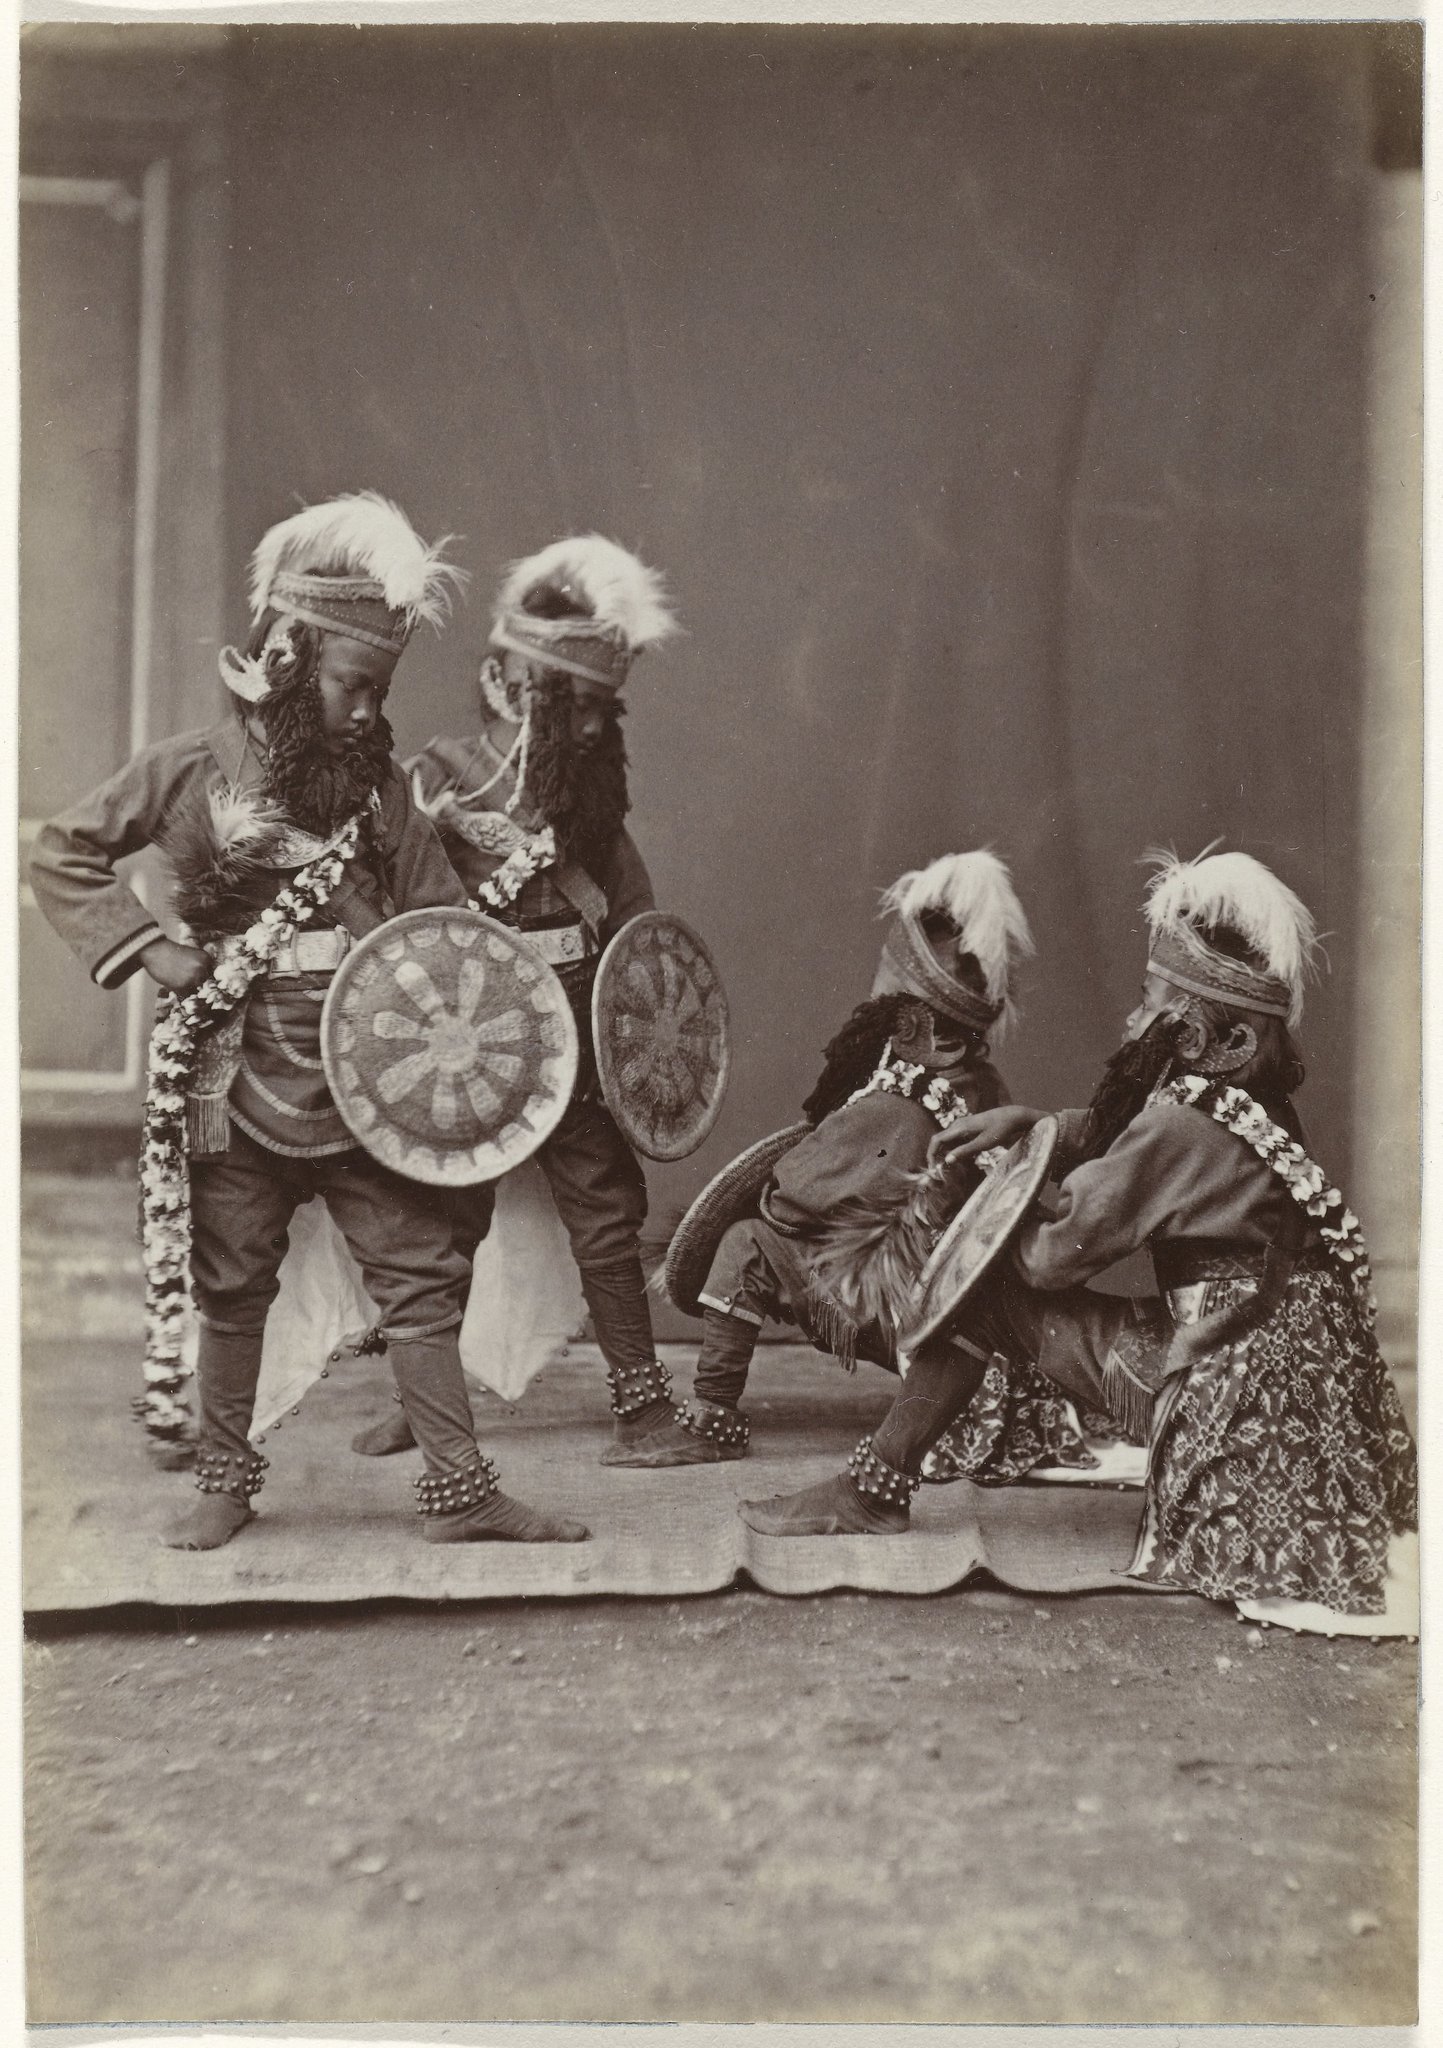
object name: photograph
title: Studioportret van vier onbekende jongens verkleed als krijgers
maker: Anonymous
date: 1870-1890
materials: paper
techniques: albumen print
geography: java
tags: boy (child between toddler and youth), anonymous historical person portrayed, trade games, imitative games, imitating adults, java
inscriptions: inscription: ‘Typen van/ Java’